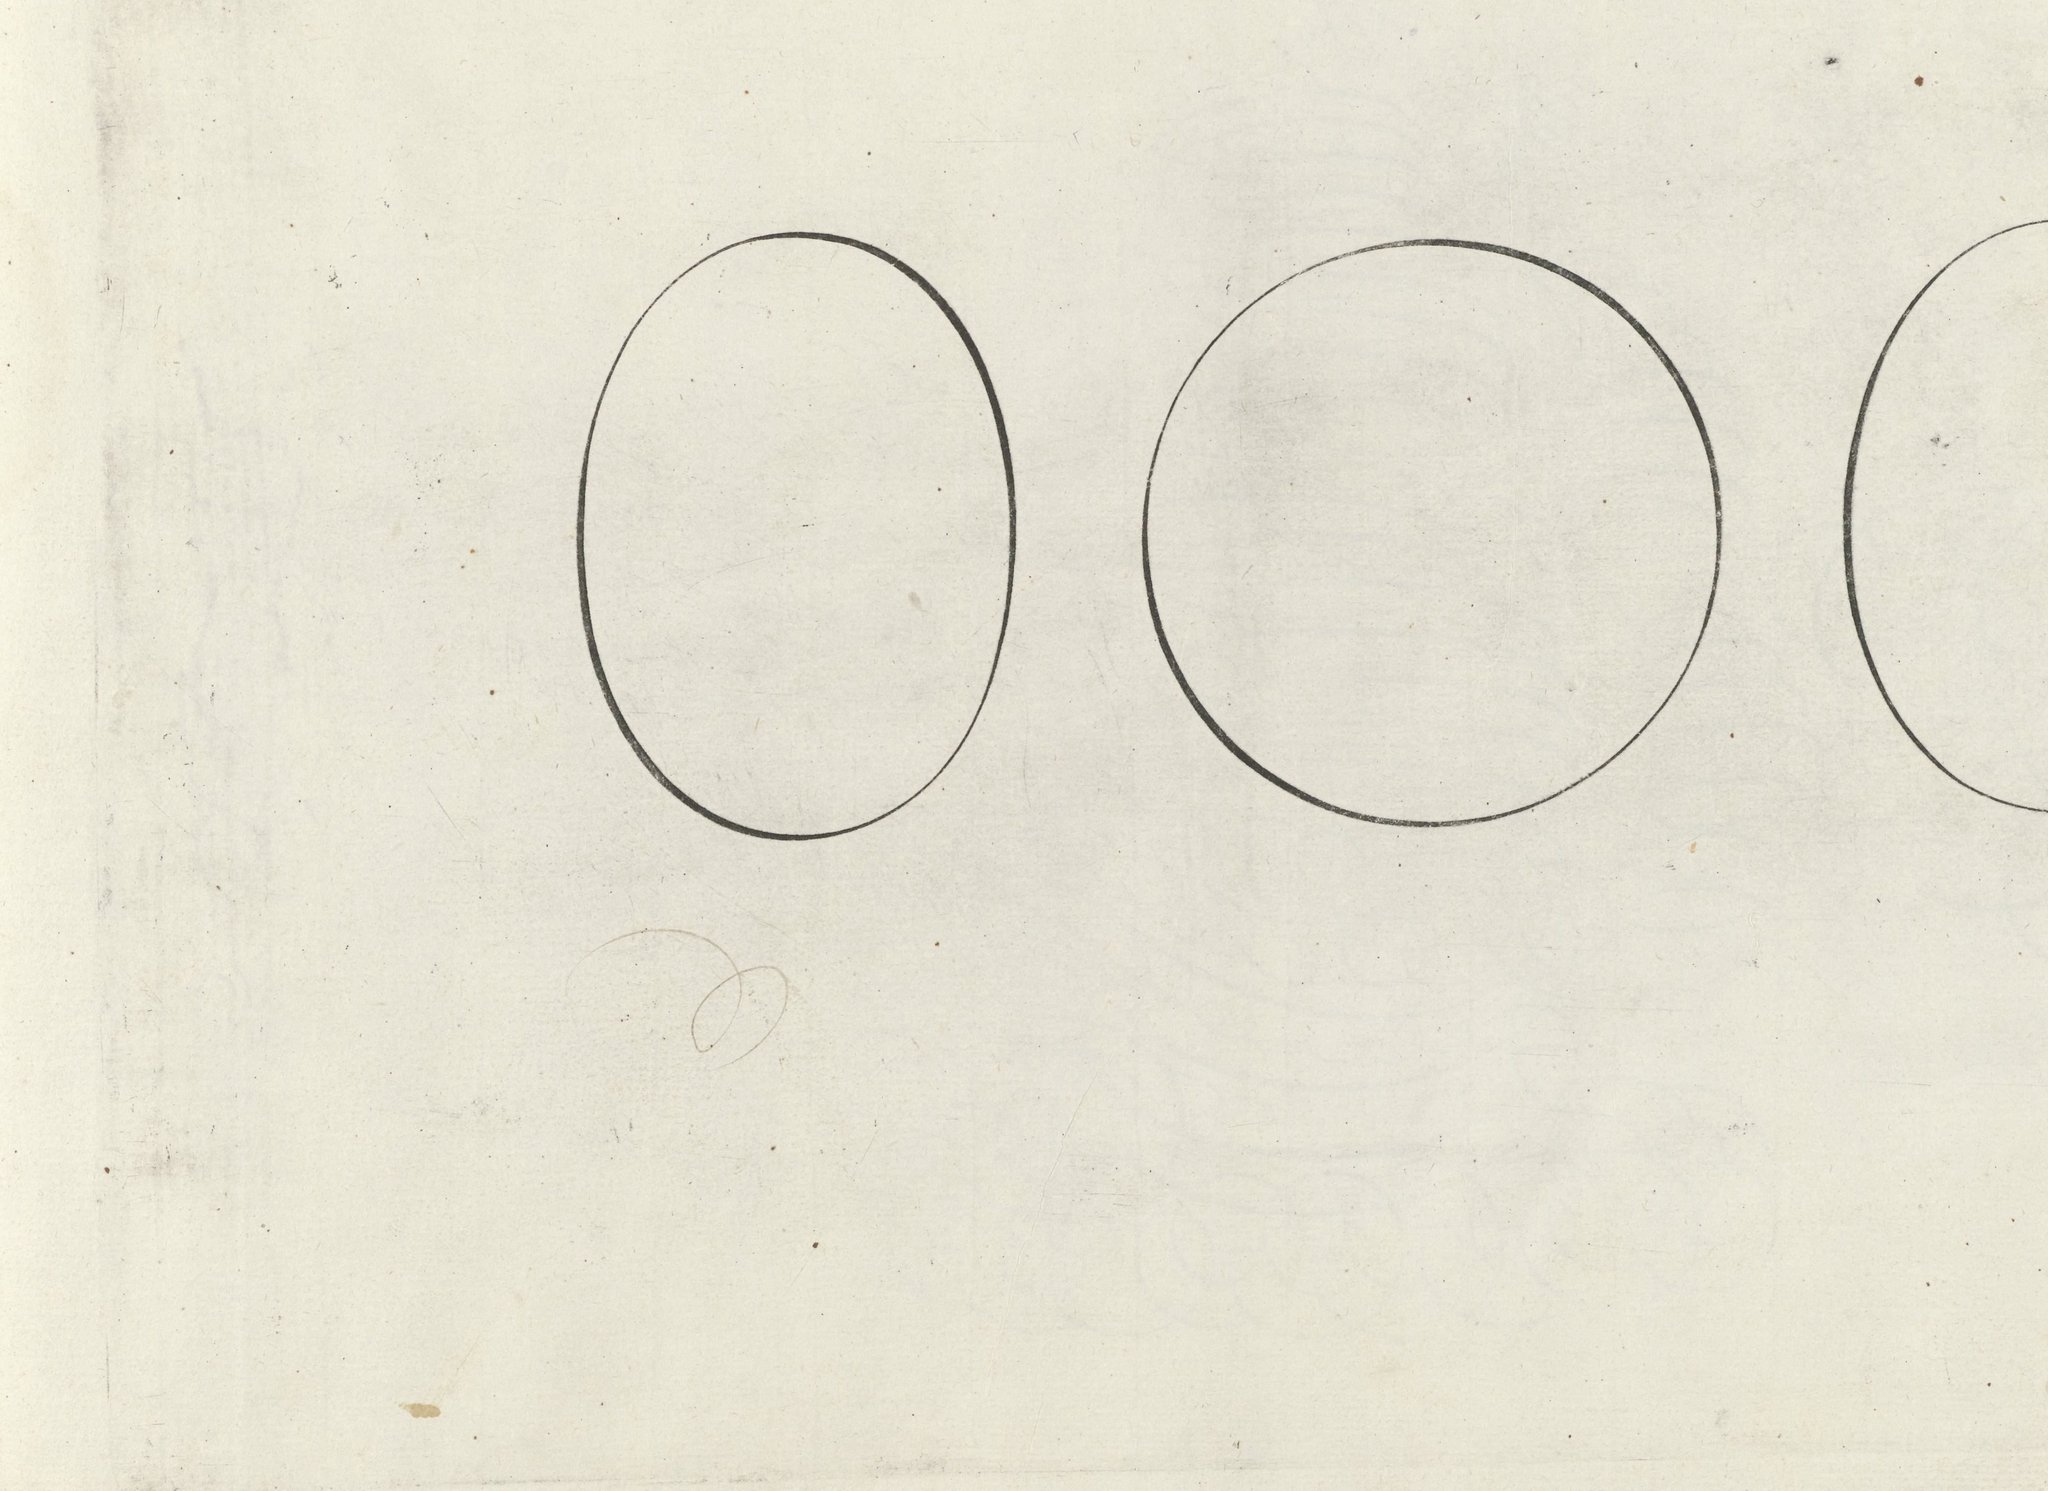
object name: album leaf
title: Spieghel der schrijfkonste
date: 1605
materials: paper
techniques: engraving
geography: amsterdam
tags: calligraphy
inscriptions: collector's mark: Lugt 2760, collector's mark: Lugt 2228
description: Van links naar rechts: een staande ovaal, cirkel en staande ovaal. De prent maakt deel uit van een album.